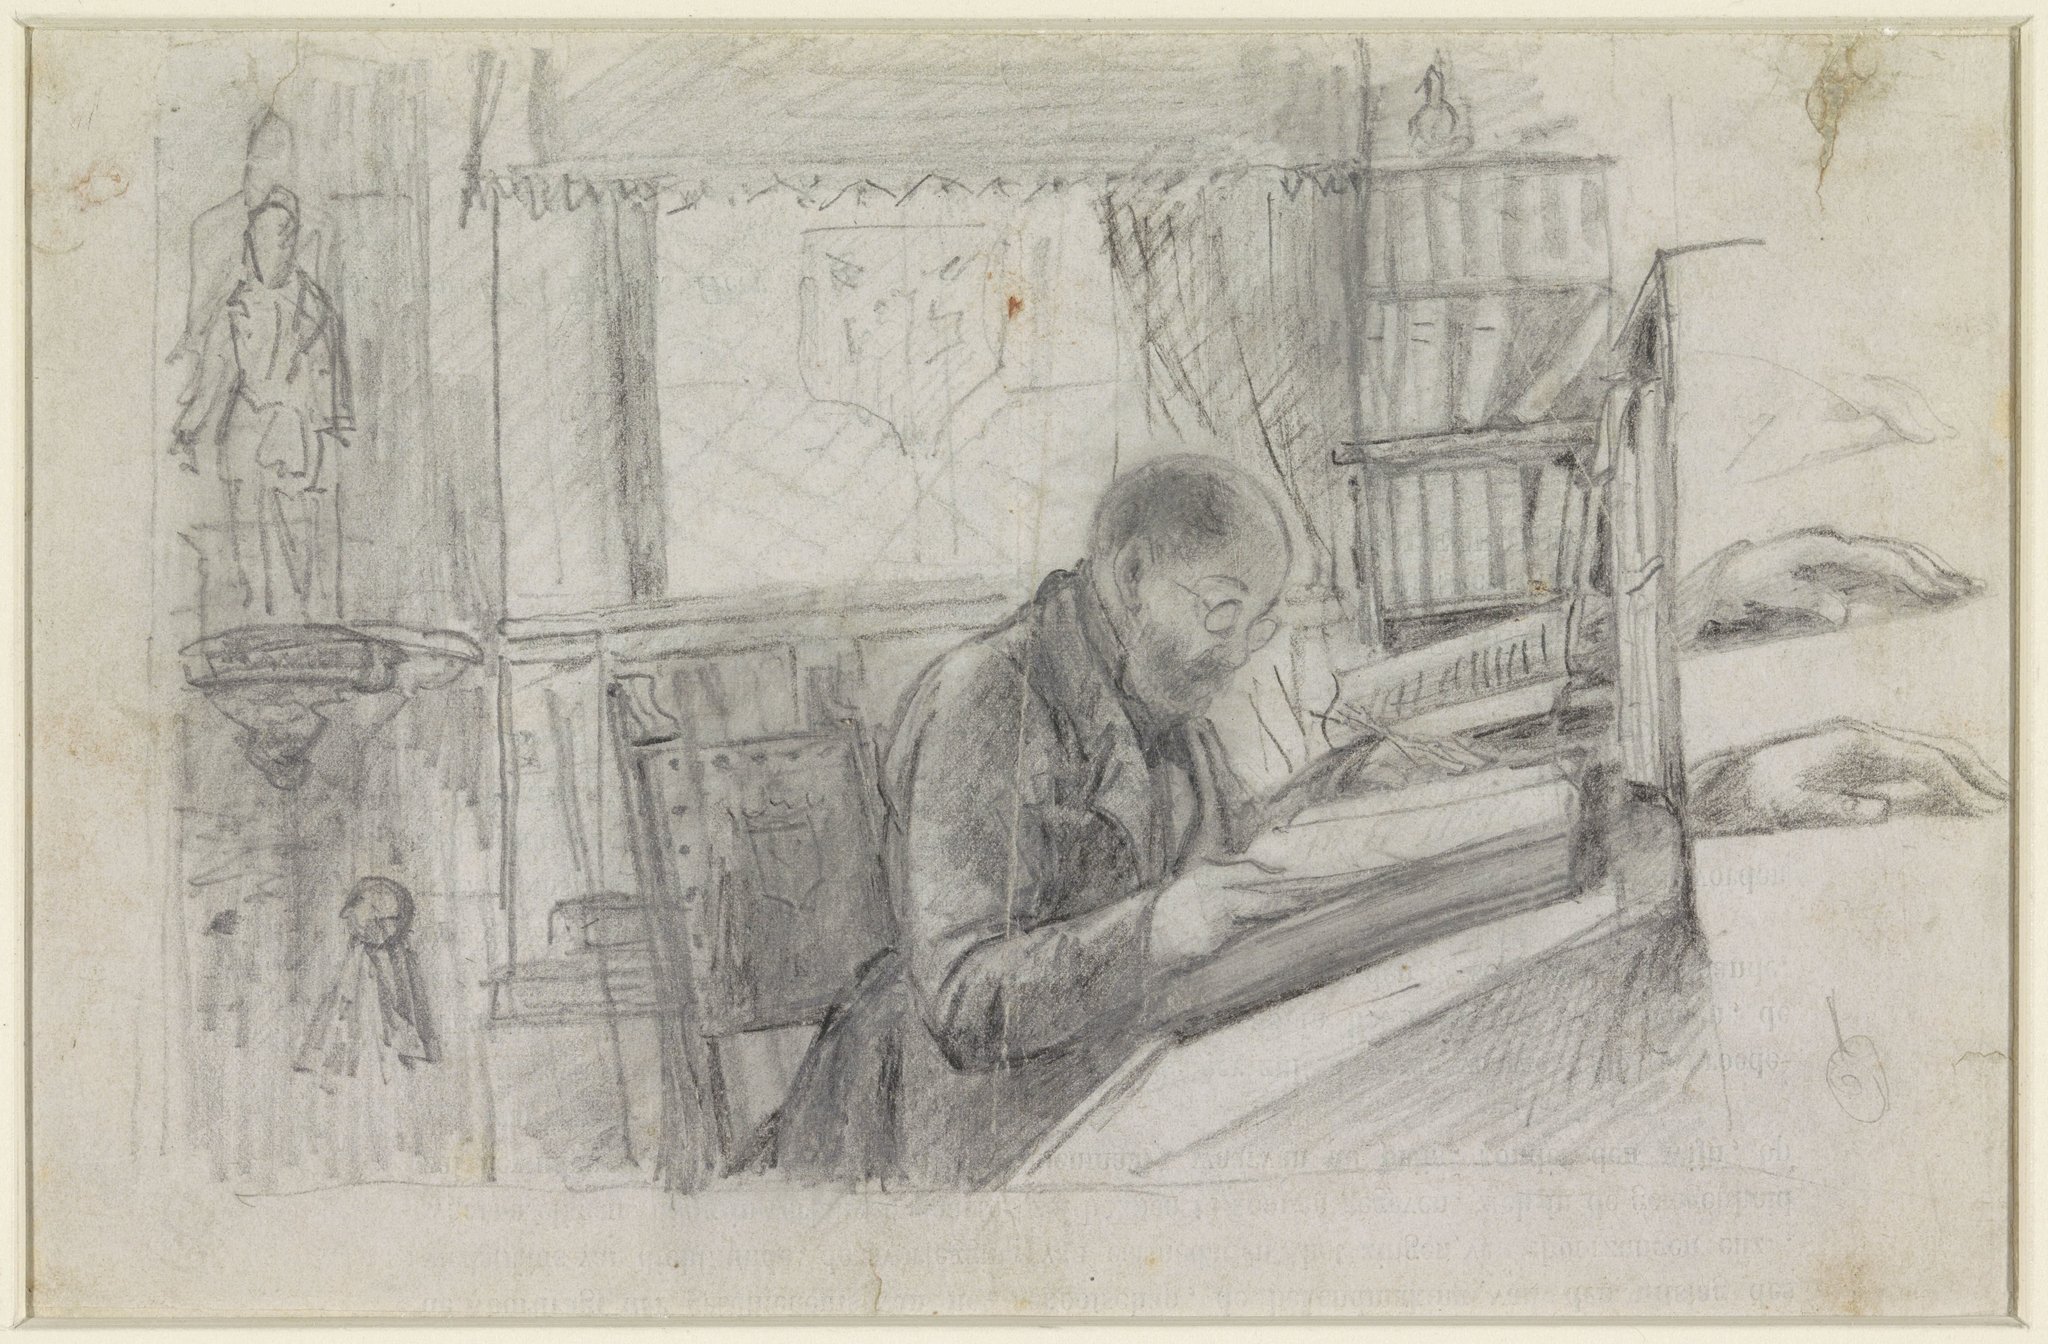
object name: drawing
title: Frederik Verachter aan zijn bureau in het archief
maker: philippus jacobus van bree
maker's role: draughtsman, print maker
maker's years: 1786-1871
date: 1800-1871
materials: chalk, paper, pencil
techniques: pouncing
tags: scholar, philosopher (+ portrait of scholar, scientist)